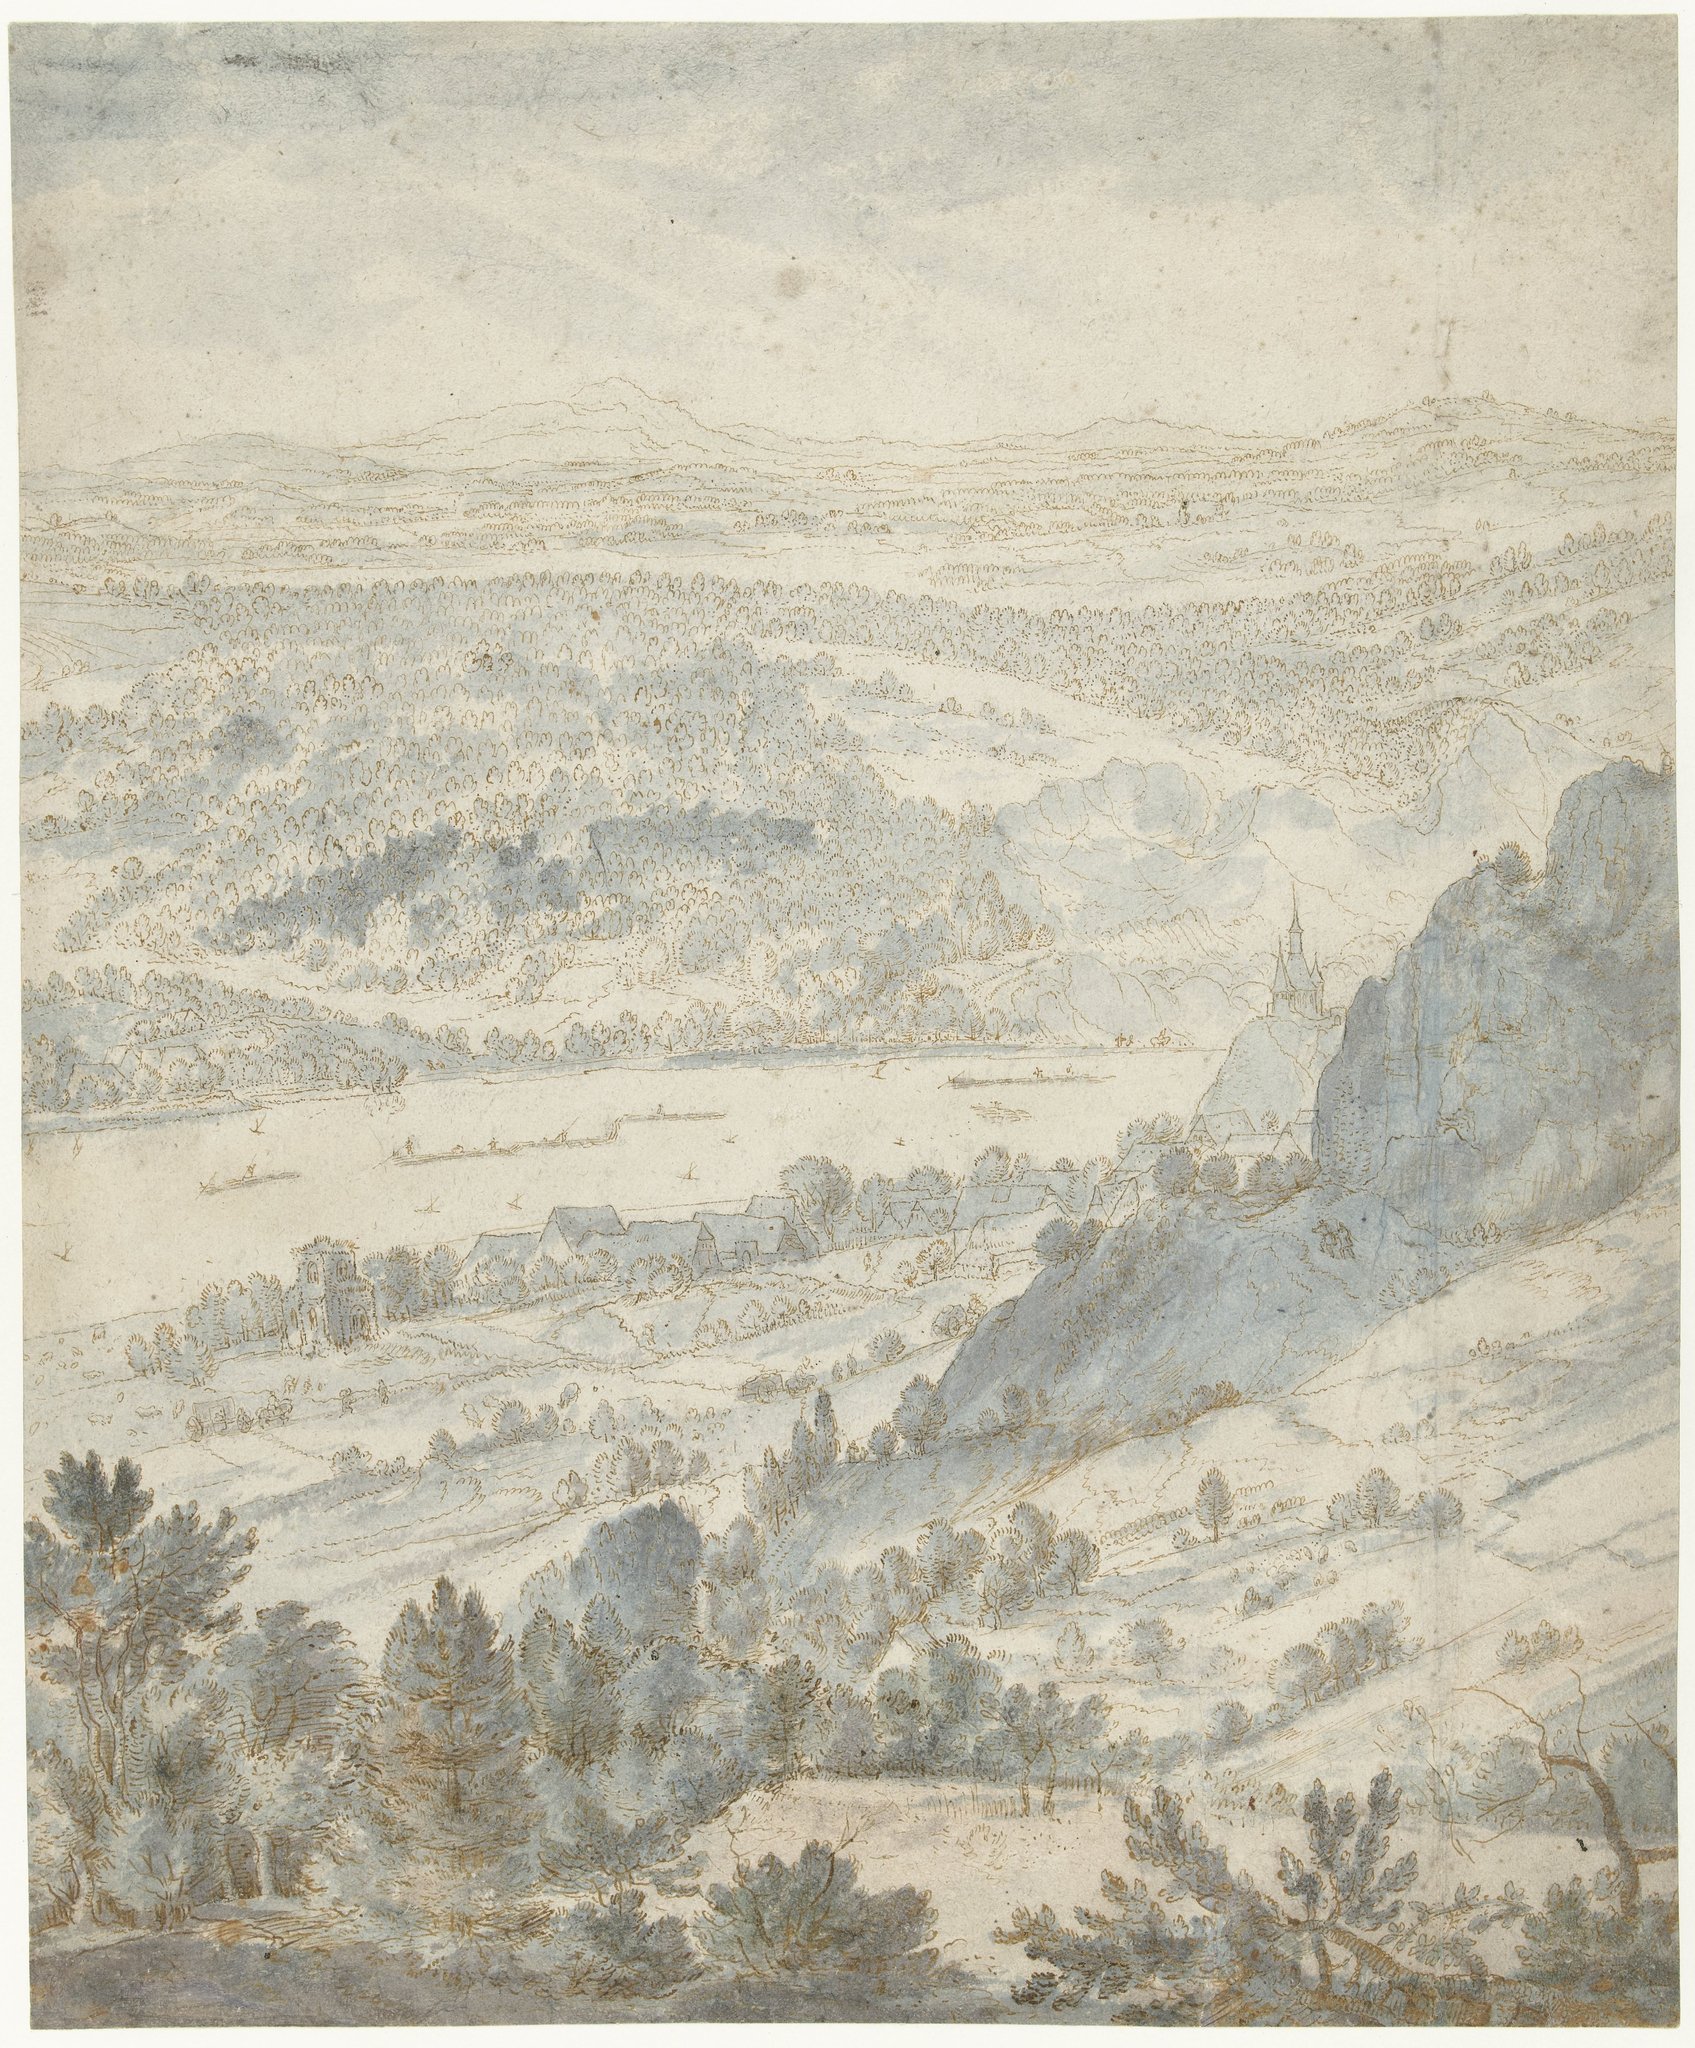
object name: drawing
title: Heuvelachtig landschap met een dorp aan een rivier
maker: roelant savery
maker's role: draughtsman, painter, print maker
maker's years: 1576-1639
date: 1603-1613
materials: ink, paper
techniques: brush, pen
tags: river, (high) hill